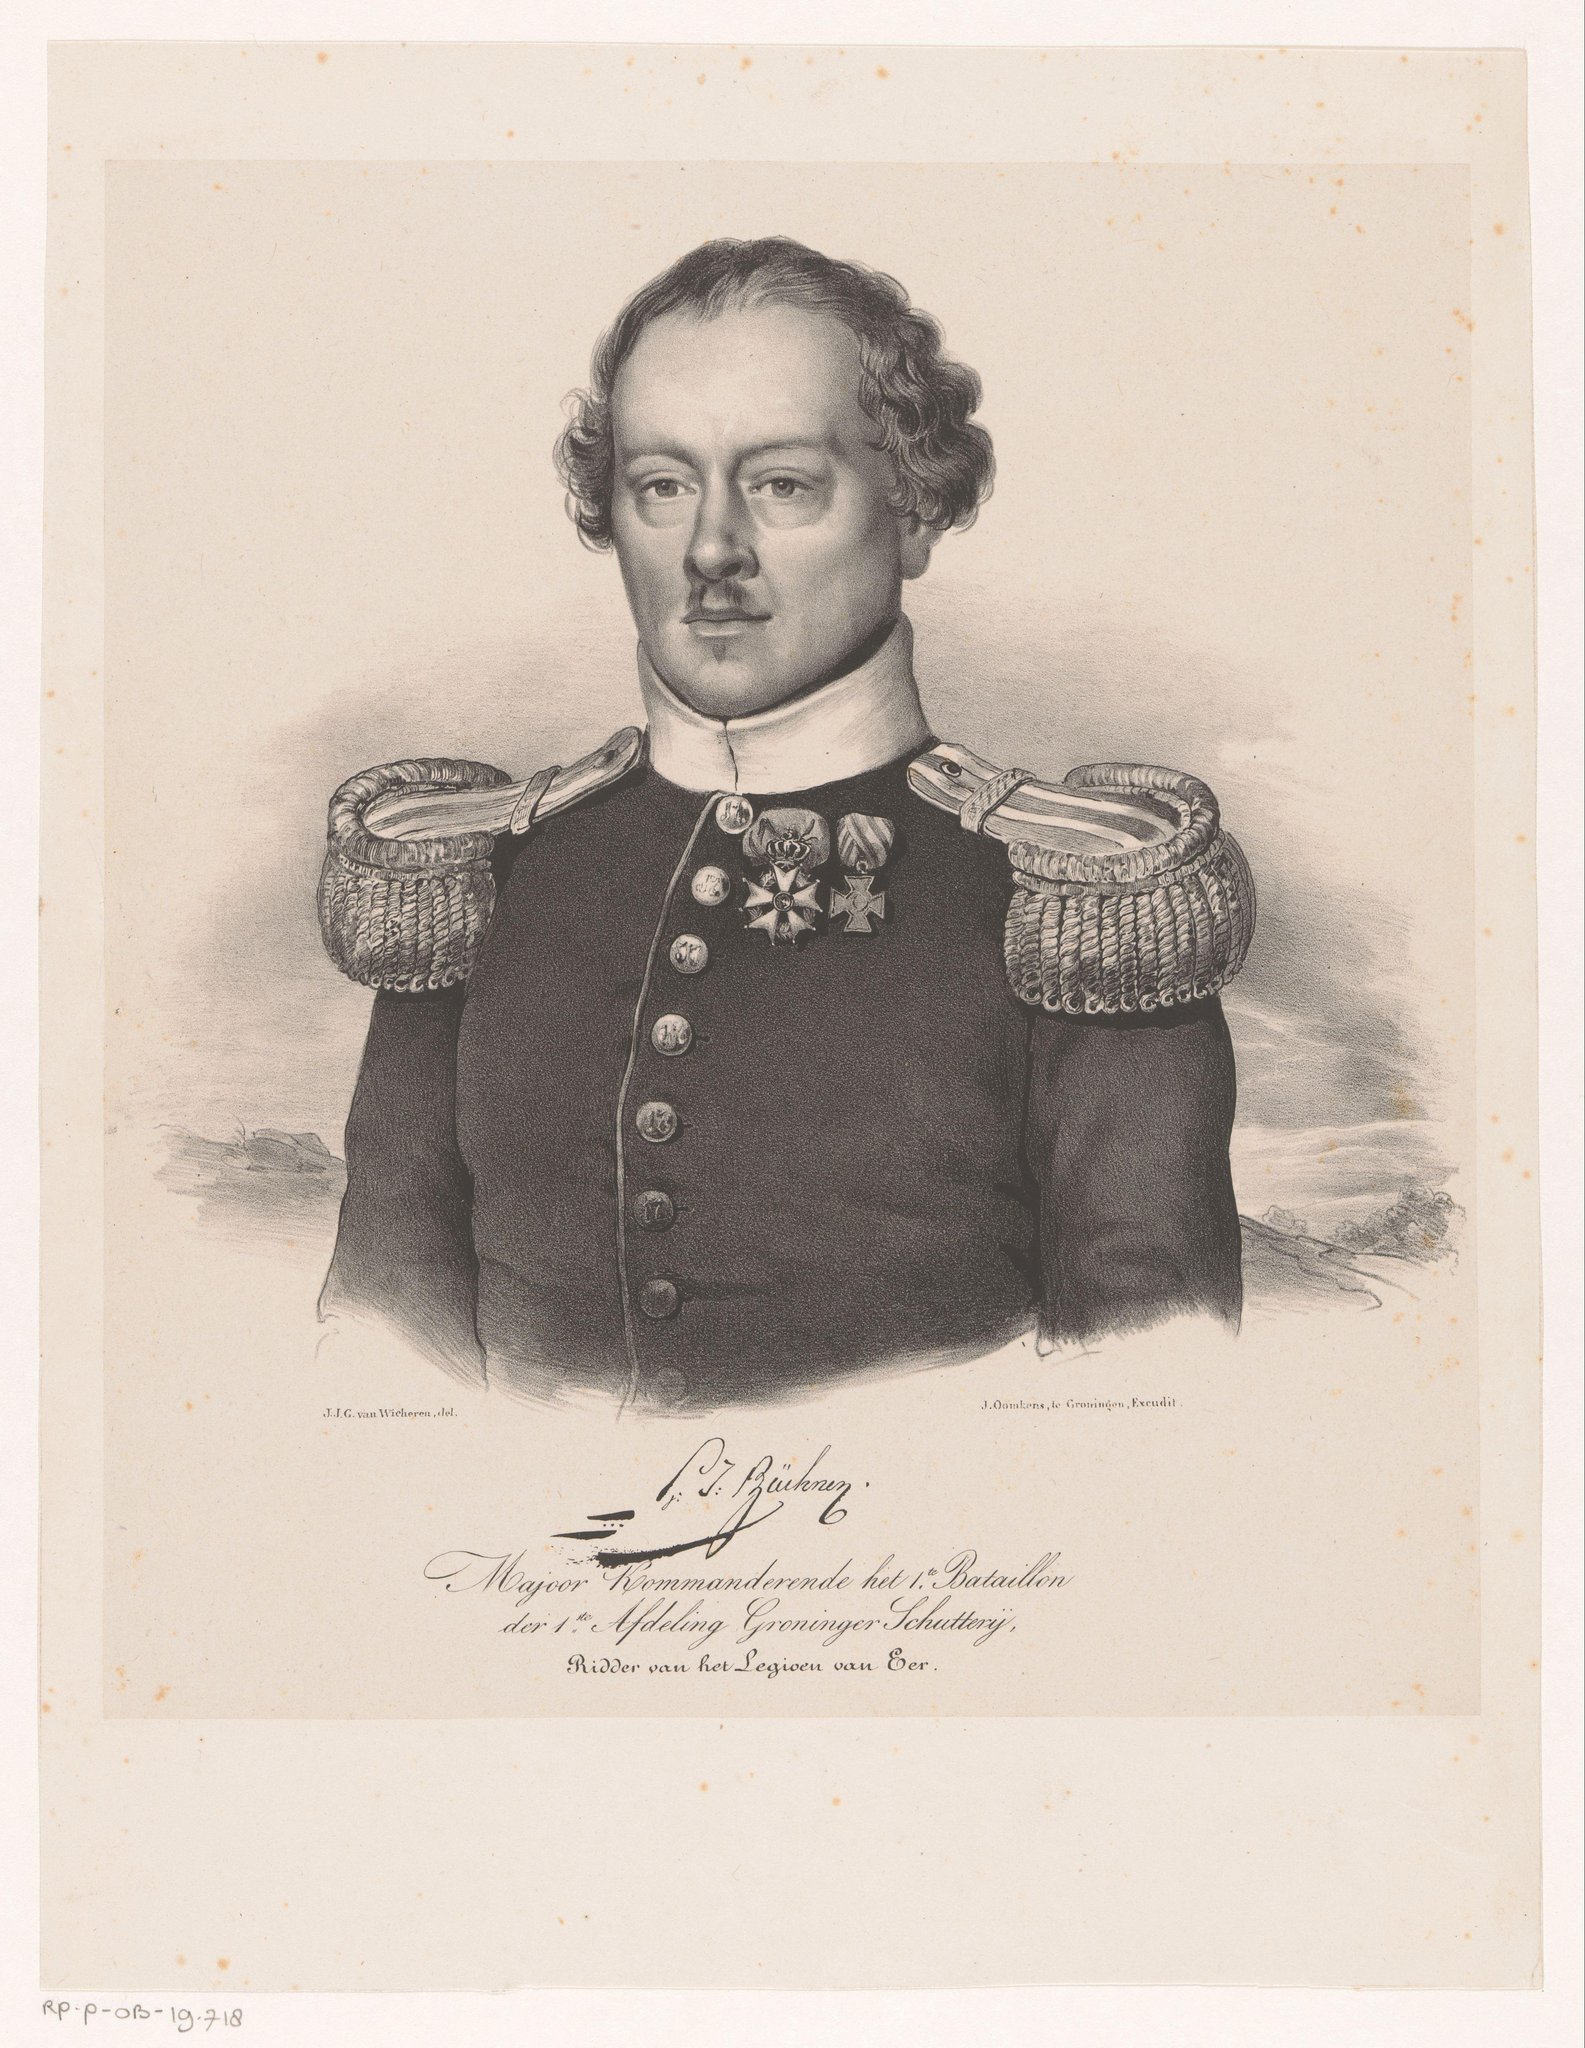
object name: print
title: Portret van G.J. Büchner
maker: jan oomkens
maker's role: bookseller, printer, publisher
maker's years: 1779-1844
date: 1818-1844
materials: paper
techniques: lithograph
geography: groningen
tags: knighthood order, historical persons (+ half-length portrait)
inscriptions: collector's mark: Lugt 2228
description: De geportretteerde draagt een militair uniform met ridderorden en epauletten. Achter hem een landschap. Onder het portret zijn signatuur, beroep en onderscheiding.